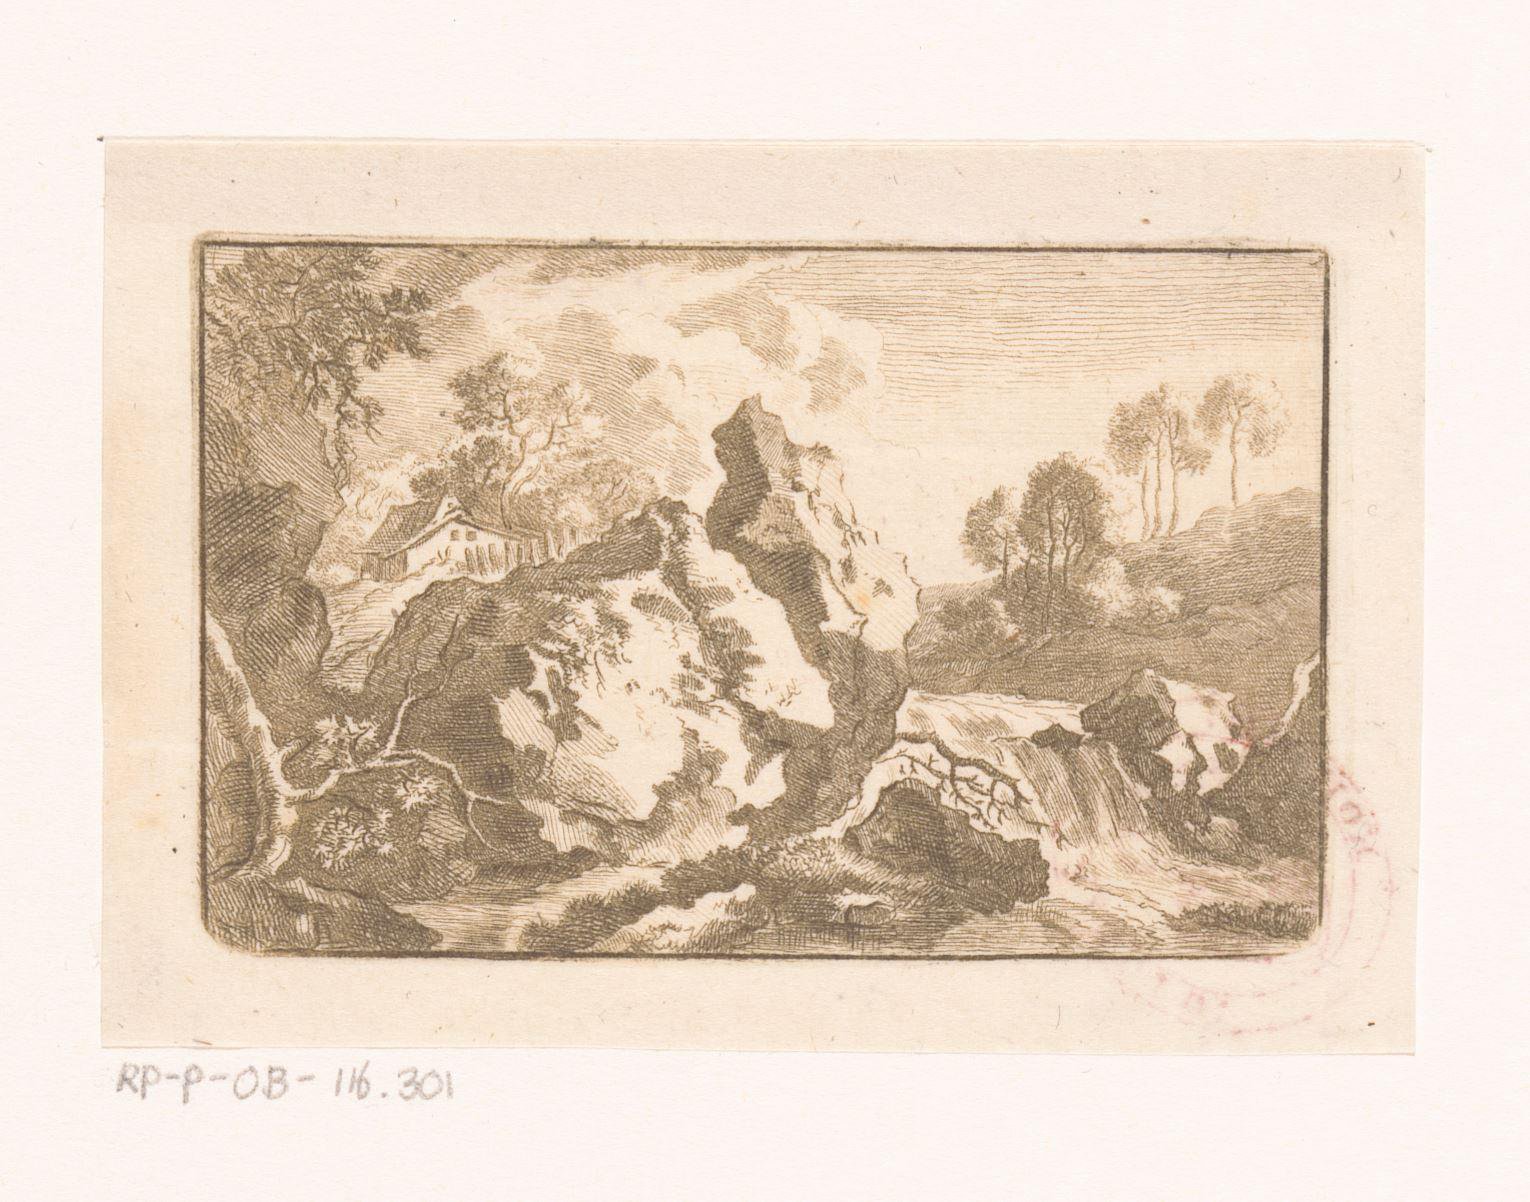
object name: print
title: Rotsachtig landschap met waterval en hut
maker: carl friedrich holtzmann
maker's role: print maker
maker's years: 1740-1811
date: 1750-1811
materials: paper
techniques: etching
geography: dresden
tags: log-cabin, waterfall, rock-formations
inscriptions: collector's mark: Lugt 240